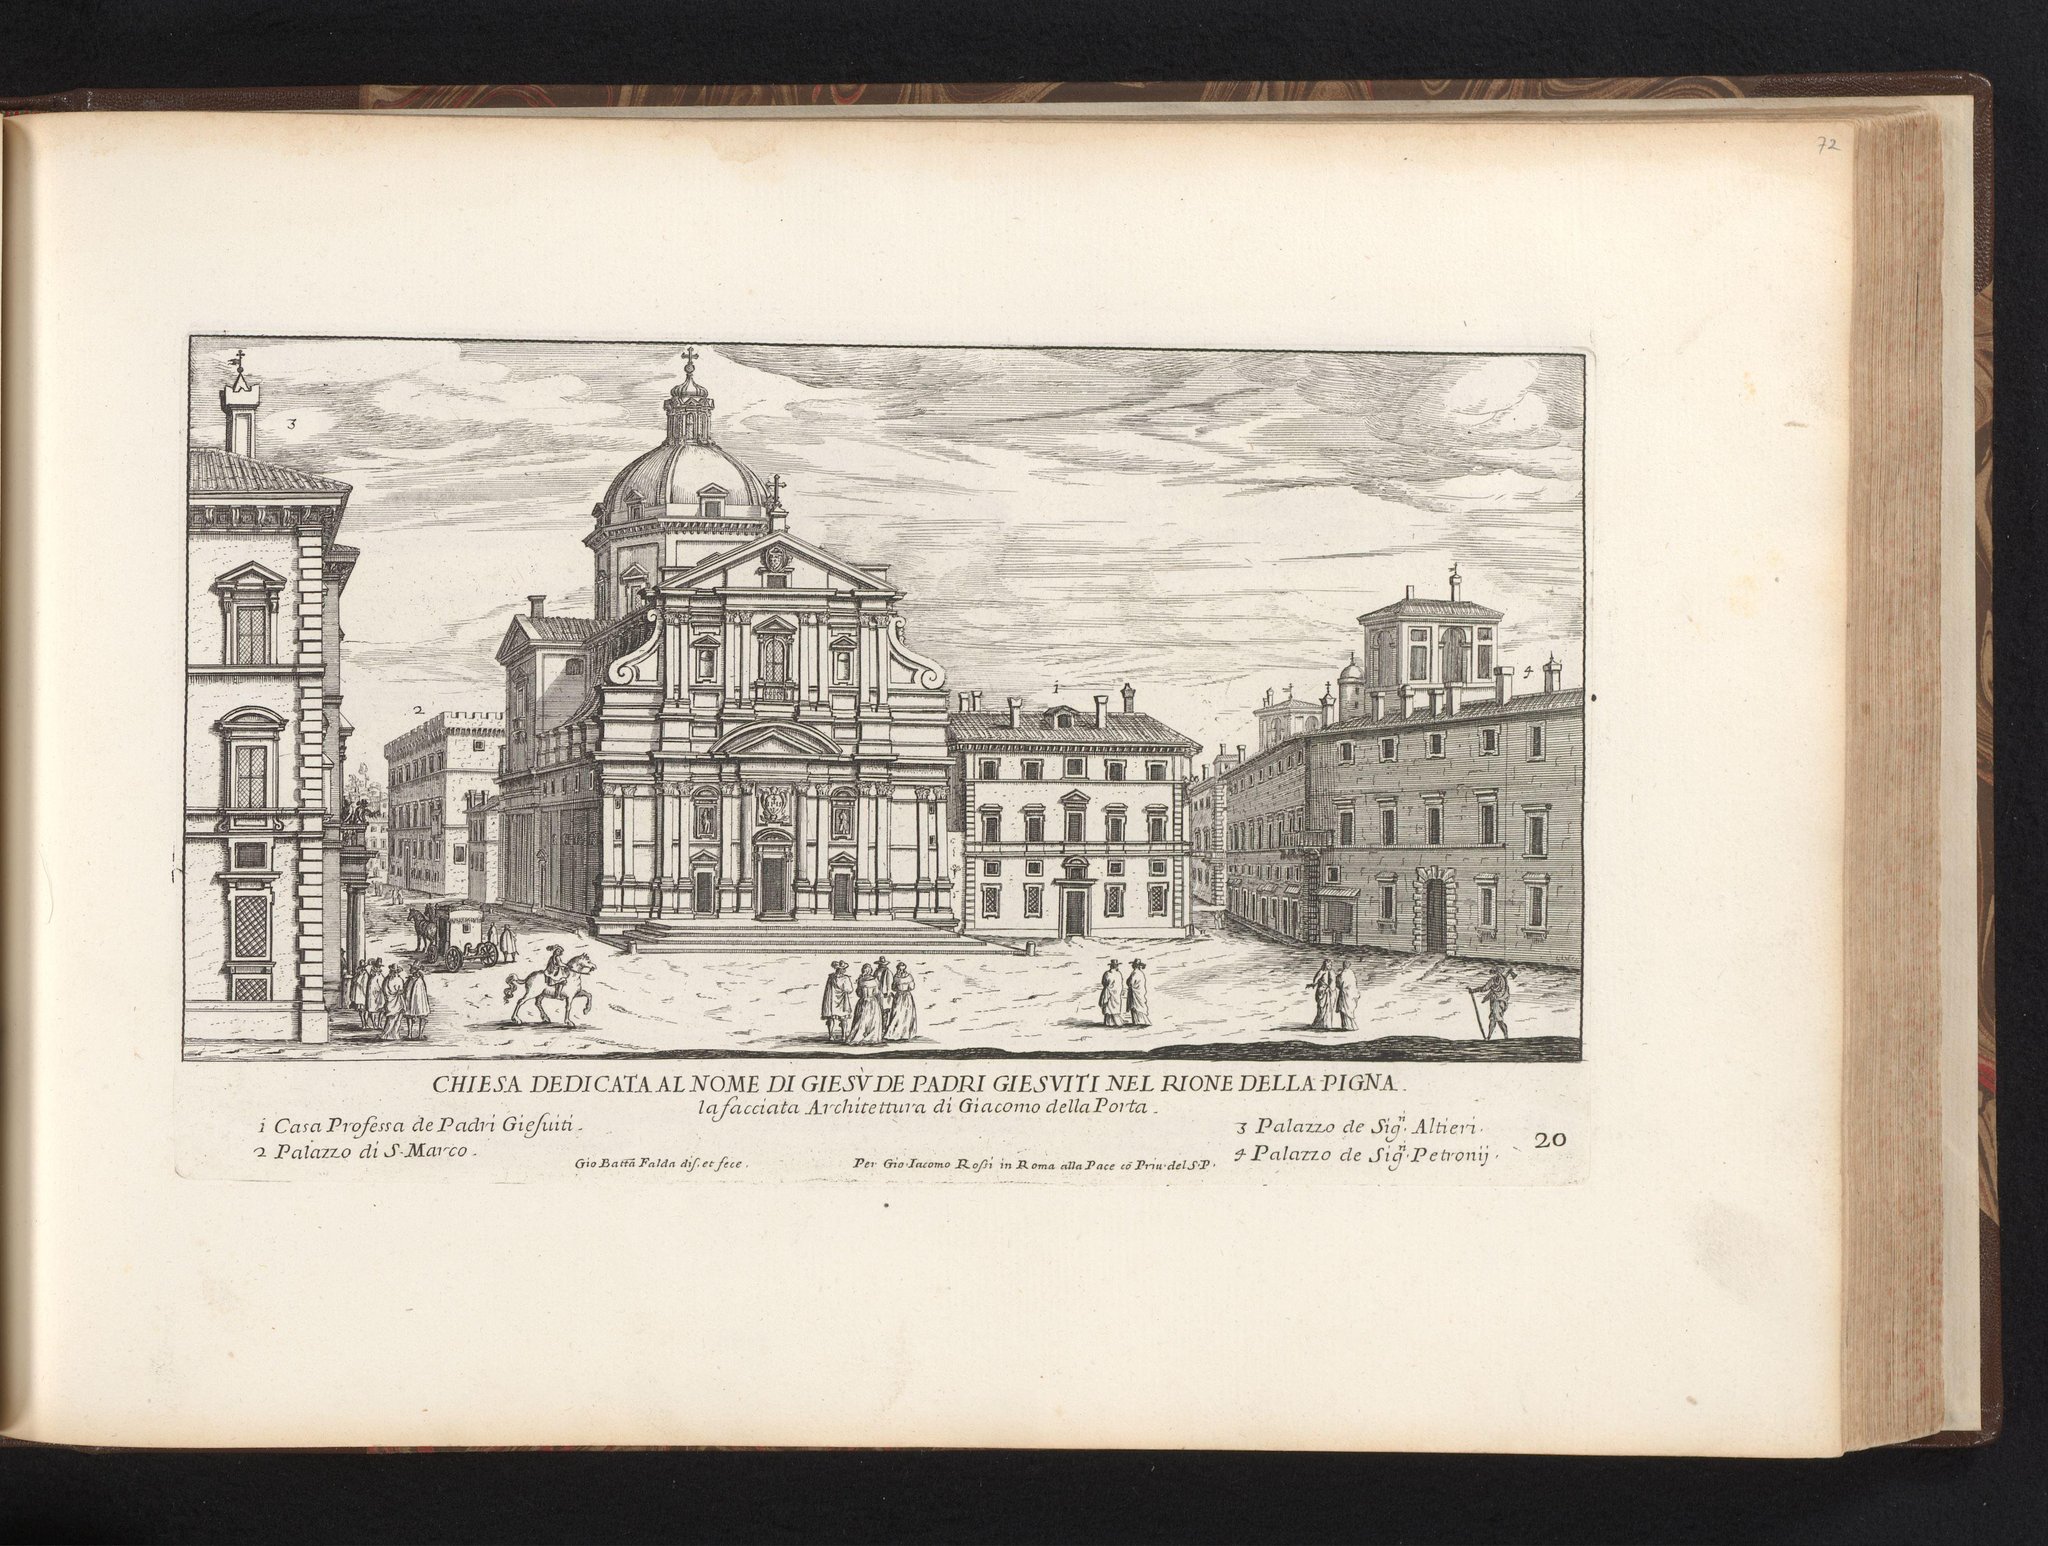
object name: album leaf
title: Il Gesù te Rome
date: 1669-1670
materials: paper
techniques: etching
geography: rome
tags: city-view, and landscape with man-made constructions, church (exterior)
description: Deze titelprent maakt deel uit van een reeks van 38 prenten met voorstellingen van kerken in Rome. Samen met vier andere reeksen vormt het de grote reeks: 'Il nuovo teatro di Roma moderna'.